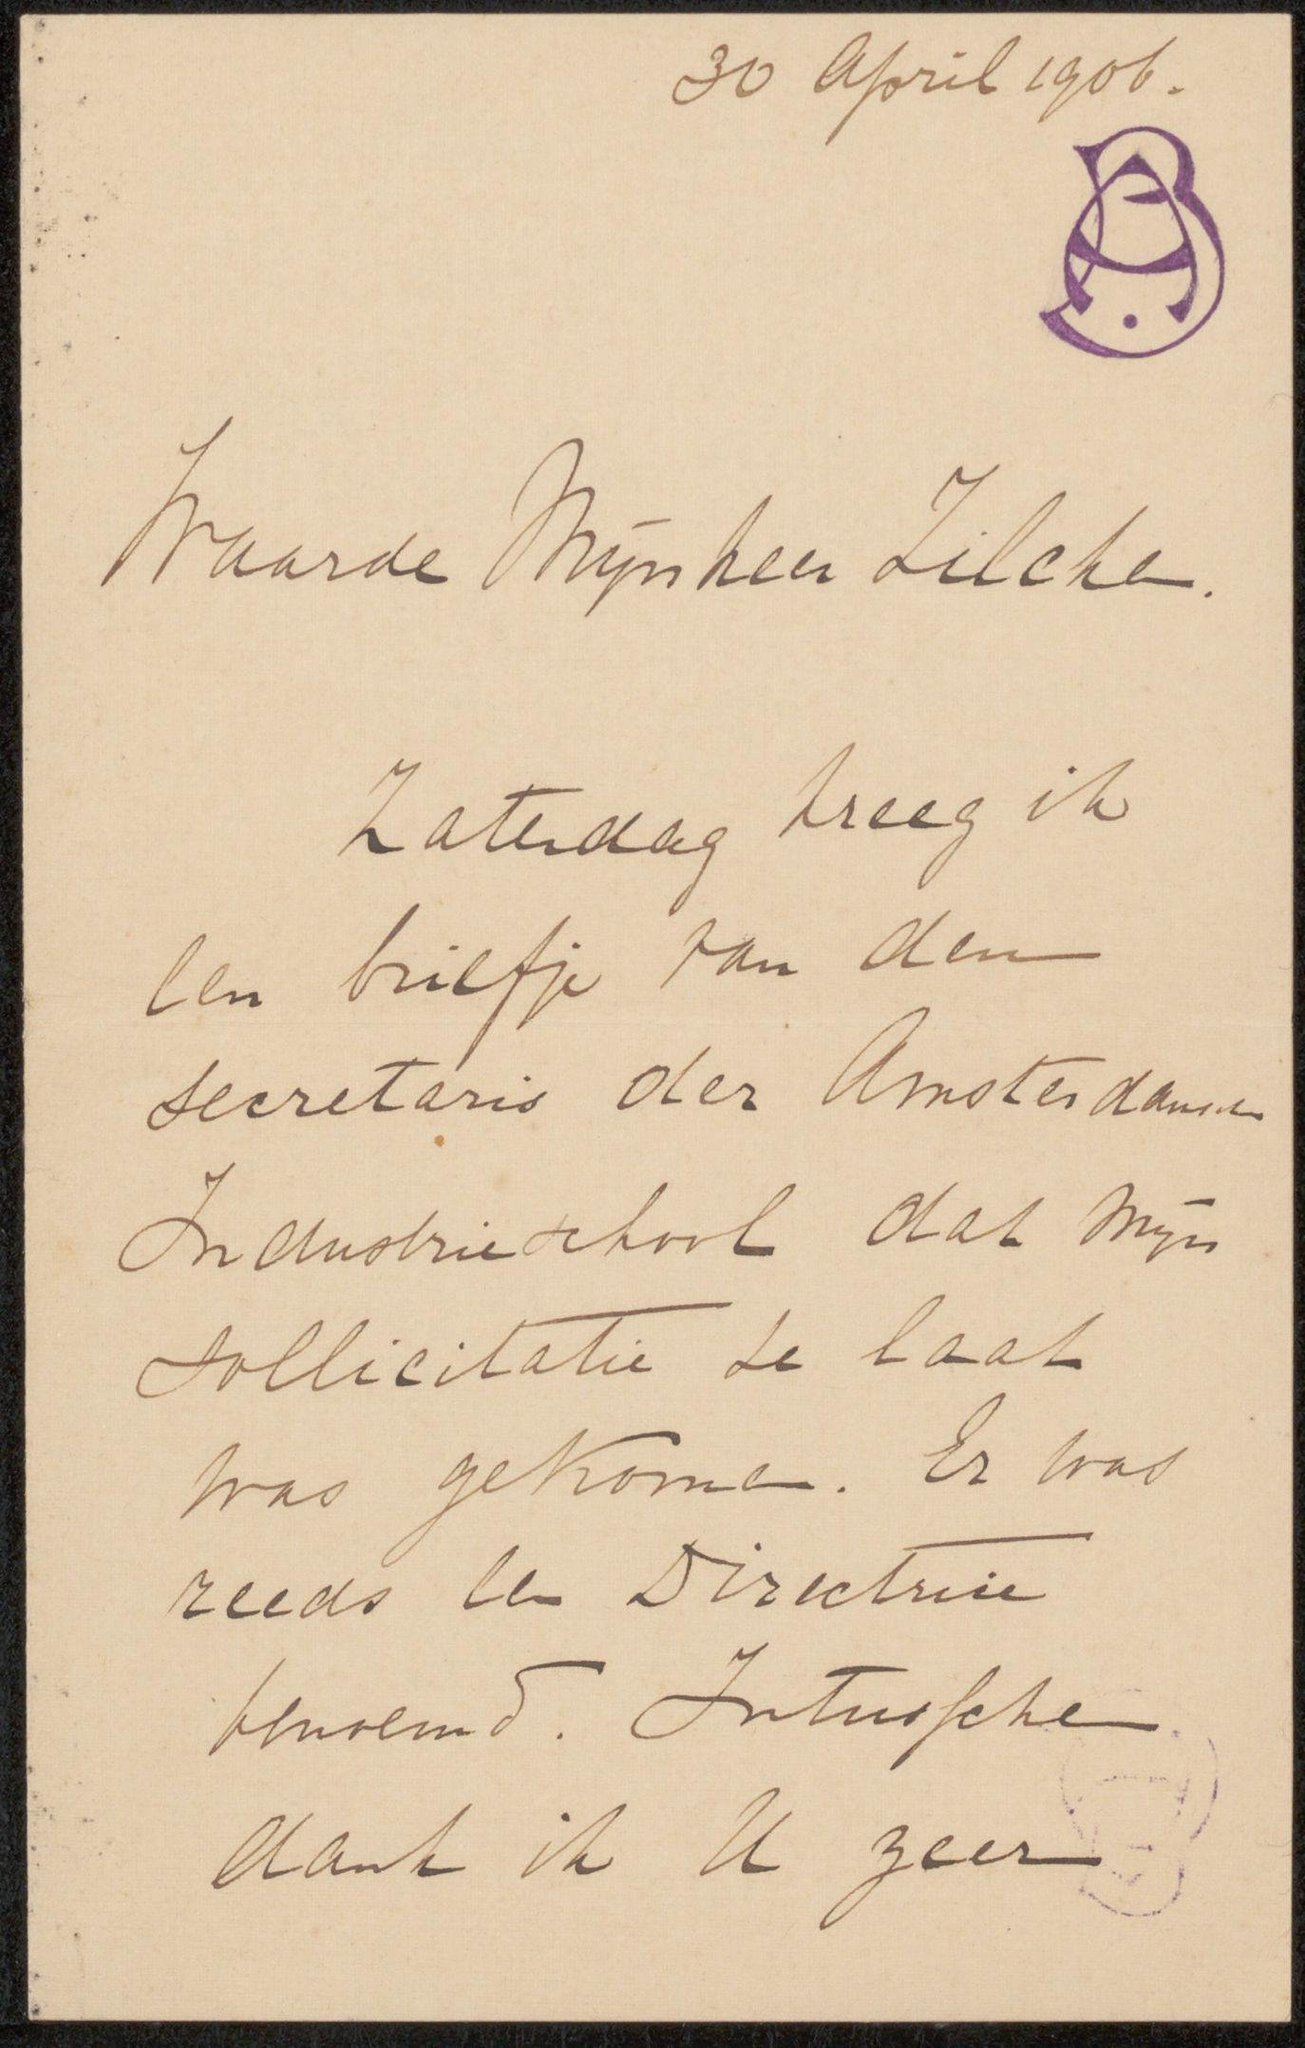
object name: letter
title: Brief aan Philip Zilcken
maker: amy bridge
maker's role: designer, draughtsman, painter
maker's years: 1867-1930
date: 1906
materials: ink, paper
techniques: pen, writing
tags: the hague, painter, draughtsman, philip zilcken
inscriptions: monogram: ‘AB’, collector's mark: ‘RPK’